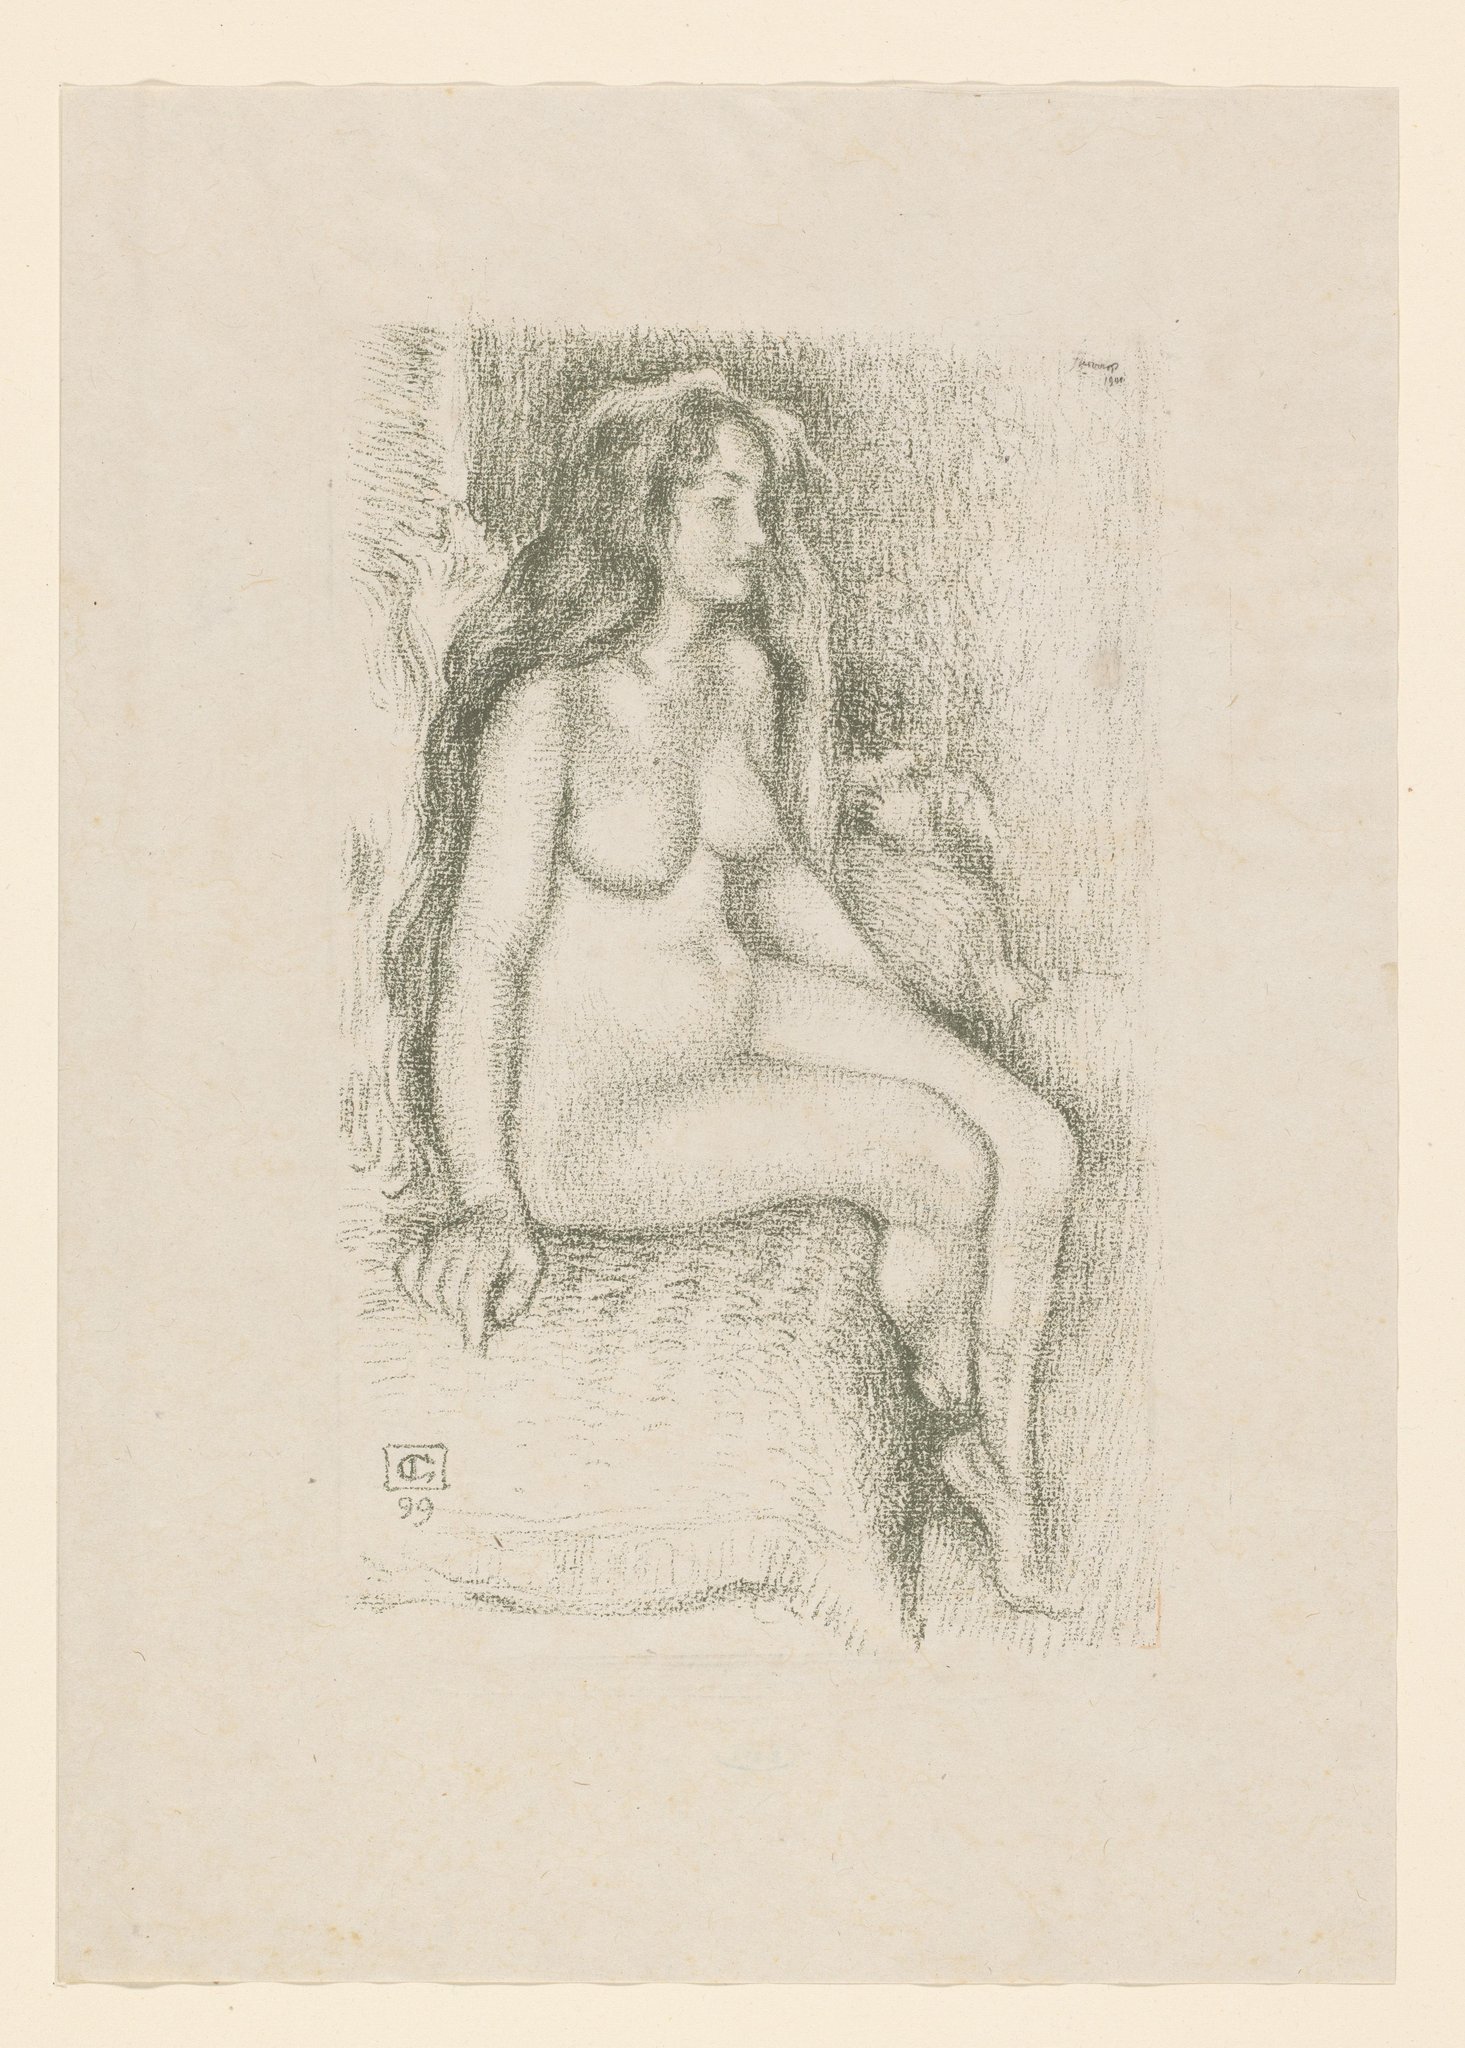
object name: print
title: Zittend naakt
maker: georges lemmen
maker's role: print maker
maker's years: 1865-1916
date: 1899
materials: paper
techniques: lithograph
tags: sitting figure, the (nude) human figure; 'corpo humano' (ripa) - aa - female human figure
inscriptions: inscription: ‘J.Toorop 1904’, inscription: ‘D 31/32’, collector's mark: Lugt 2228